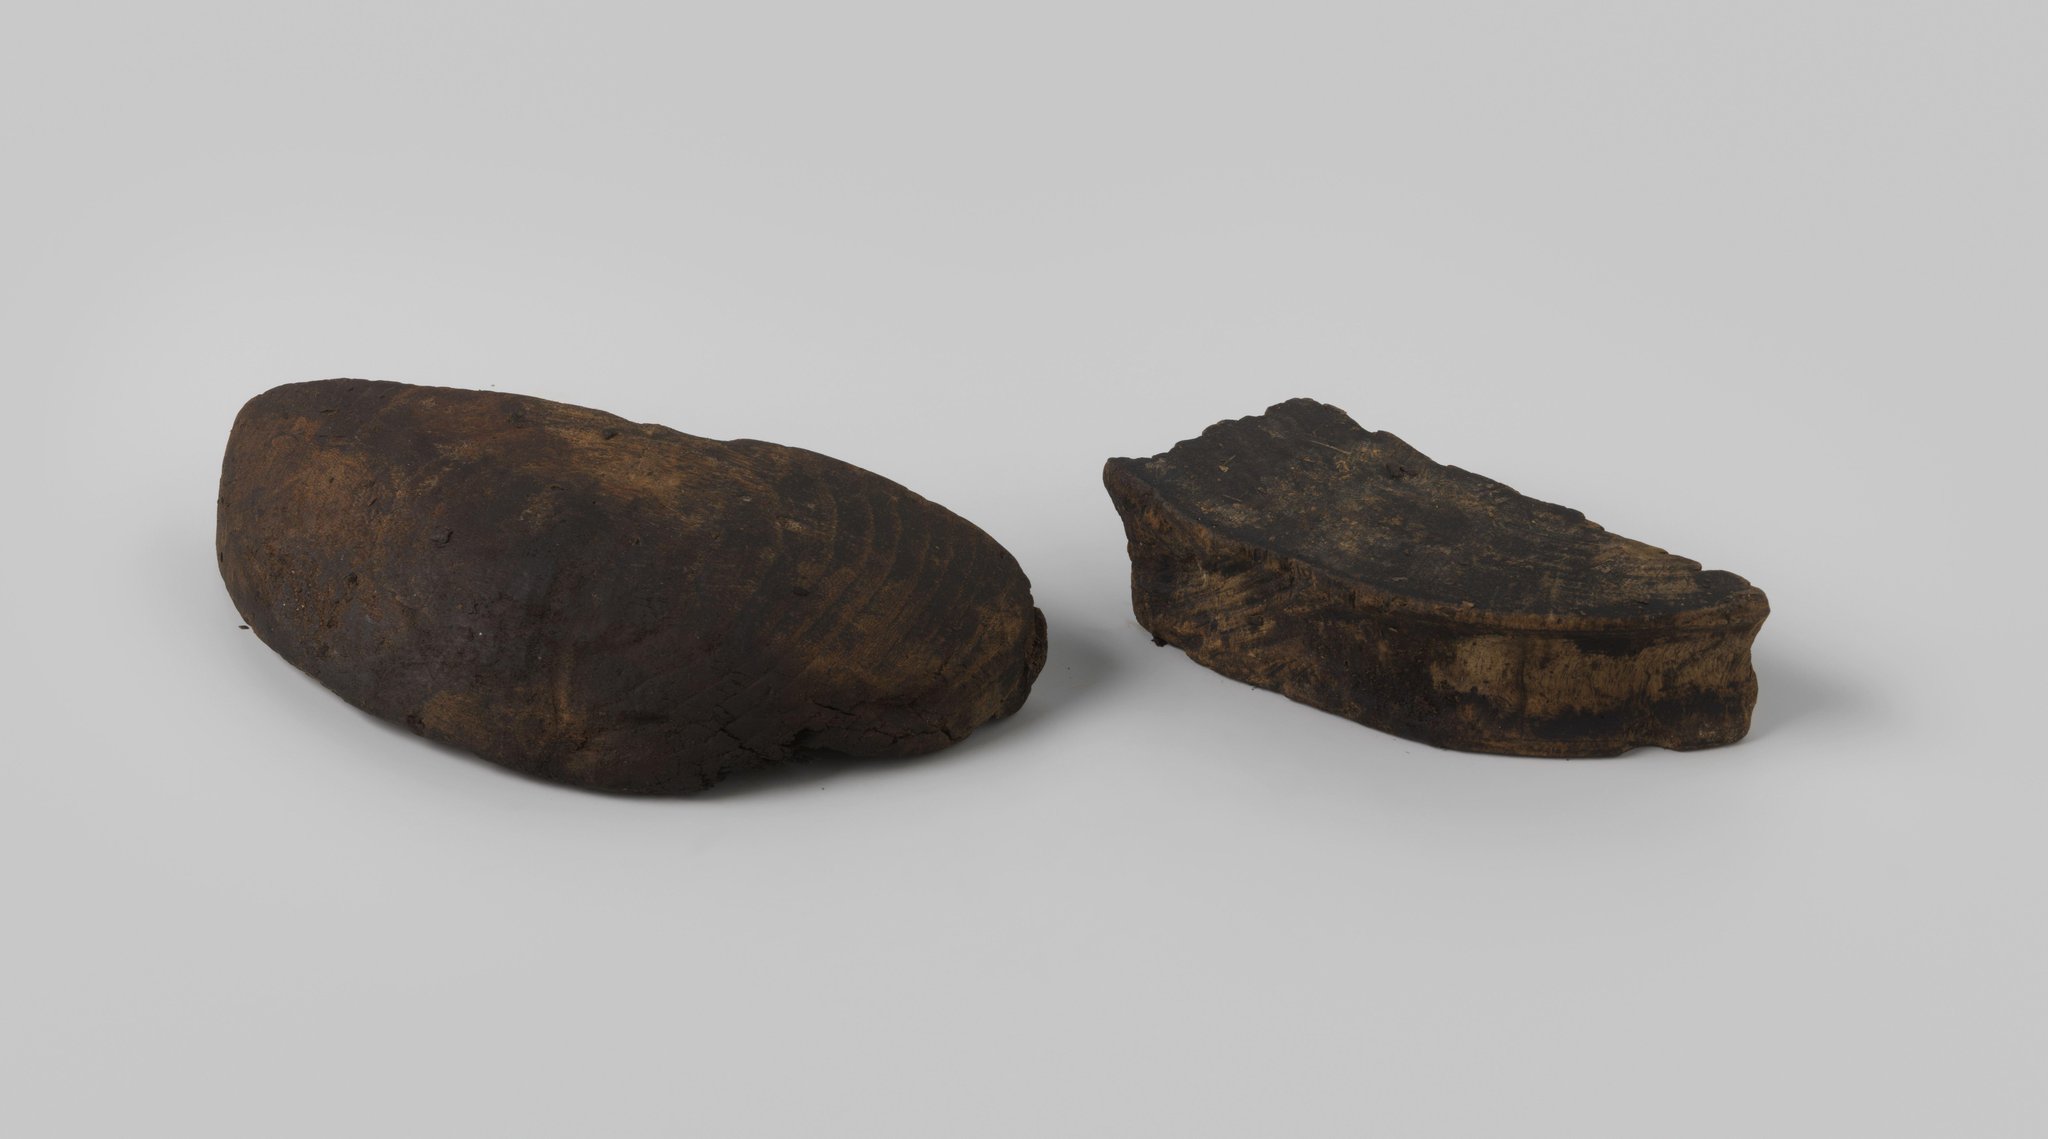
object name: block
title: Fragmenten schijven van katrollen uit het wrak van de Oost-Indiëvaarder Hollandia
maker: Anonymous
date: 1700-1743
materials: wood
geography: netherlands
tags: verenigde oostindische compagnie, hollandia (schip), annet